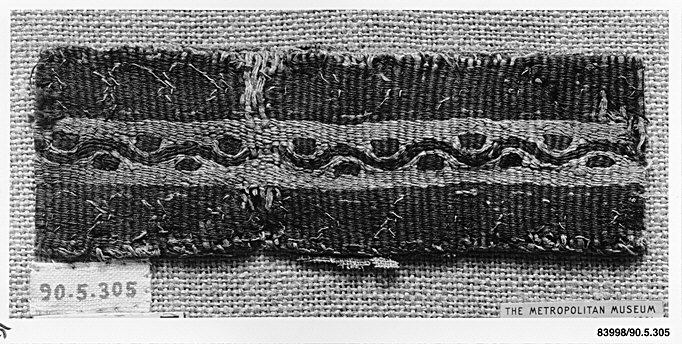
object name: textile fragment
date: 201-400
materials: linen, wool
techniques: weave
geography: egypt